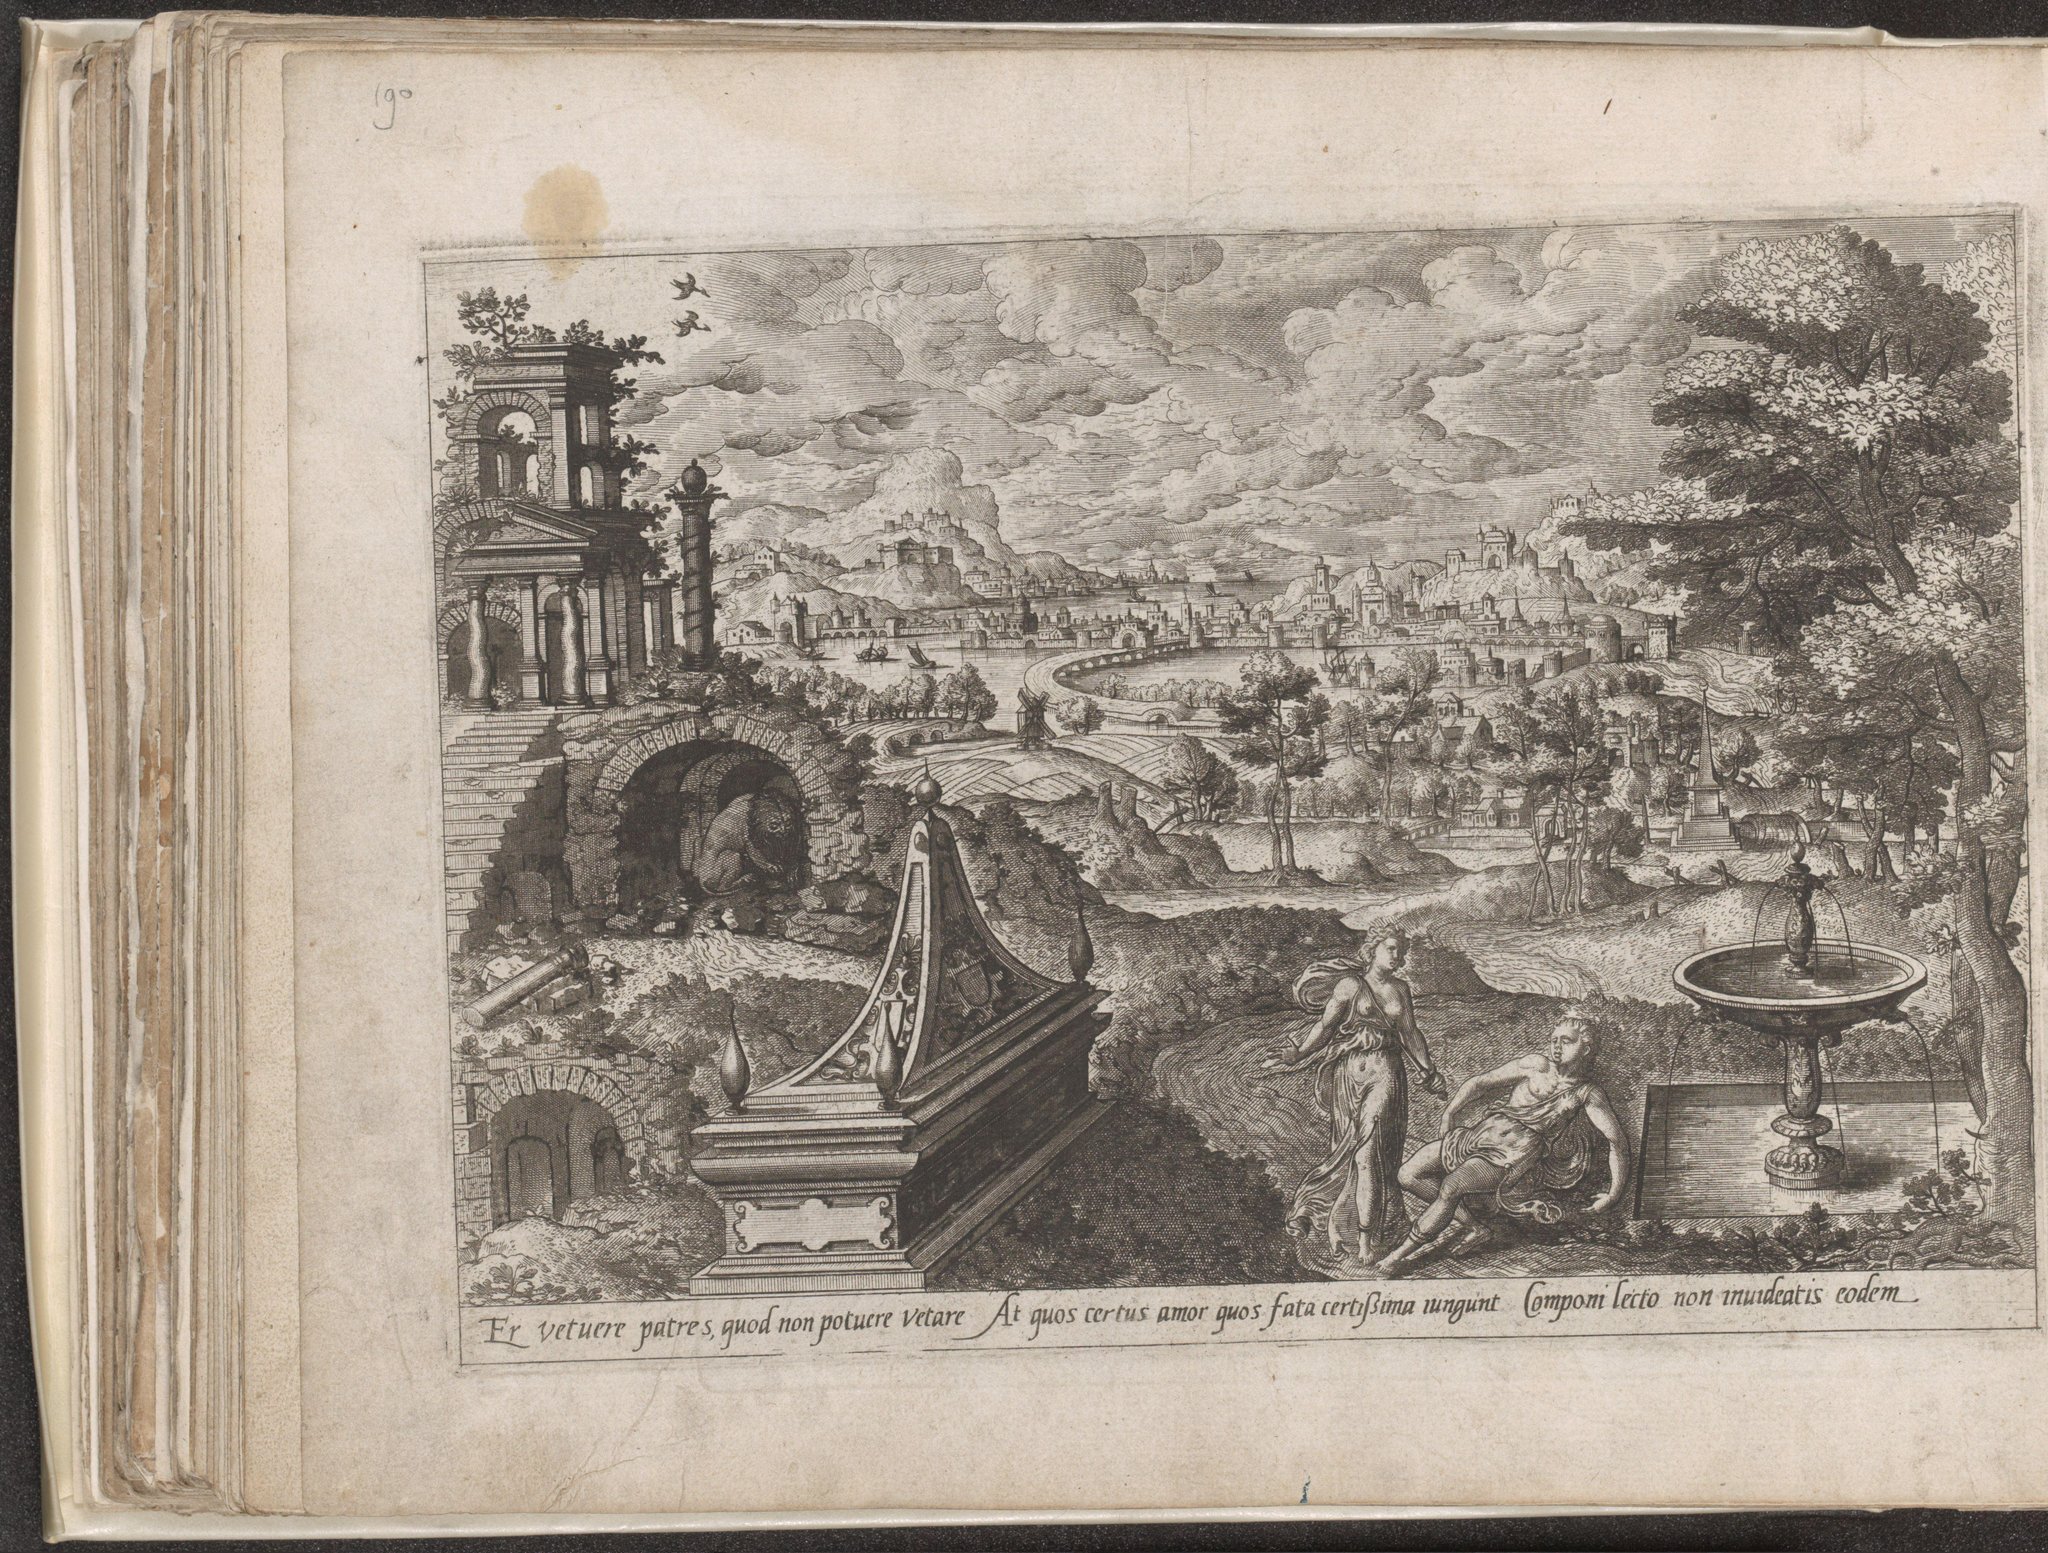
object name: album leaf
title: Pyramus en Thisbe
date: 1570-1574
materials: paper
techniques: etching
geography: antwerp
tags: thisbe kills herself with pyramus' sword (the scene may be represented near a fountain)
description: De overleden Pyramus ligt bij de fontein. Hij heeft zichzelf neergestoken met zijn zwaard, omdat hij dacht dat Thisbe door een leeuw was gedood. Thisbe ontdekt haar stervende geliefde, waarop zij zelfmoord pleegt met het zwaard van Pyramus. Links op de achtergrond zit de leeuw onder een stenen boog. Onder de voorstelling een verklarende tekst in het Latijn. Deze prent maakt deel uit van een album.